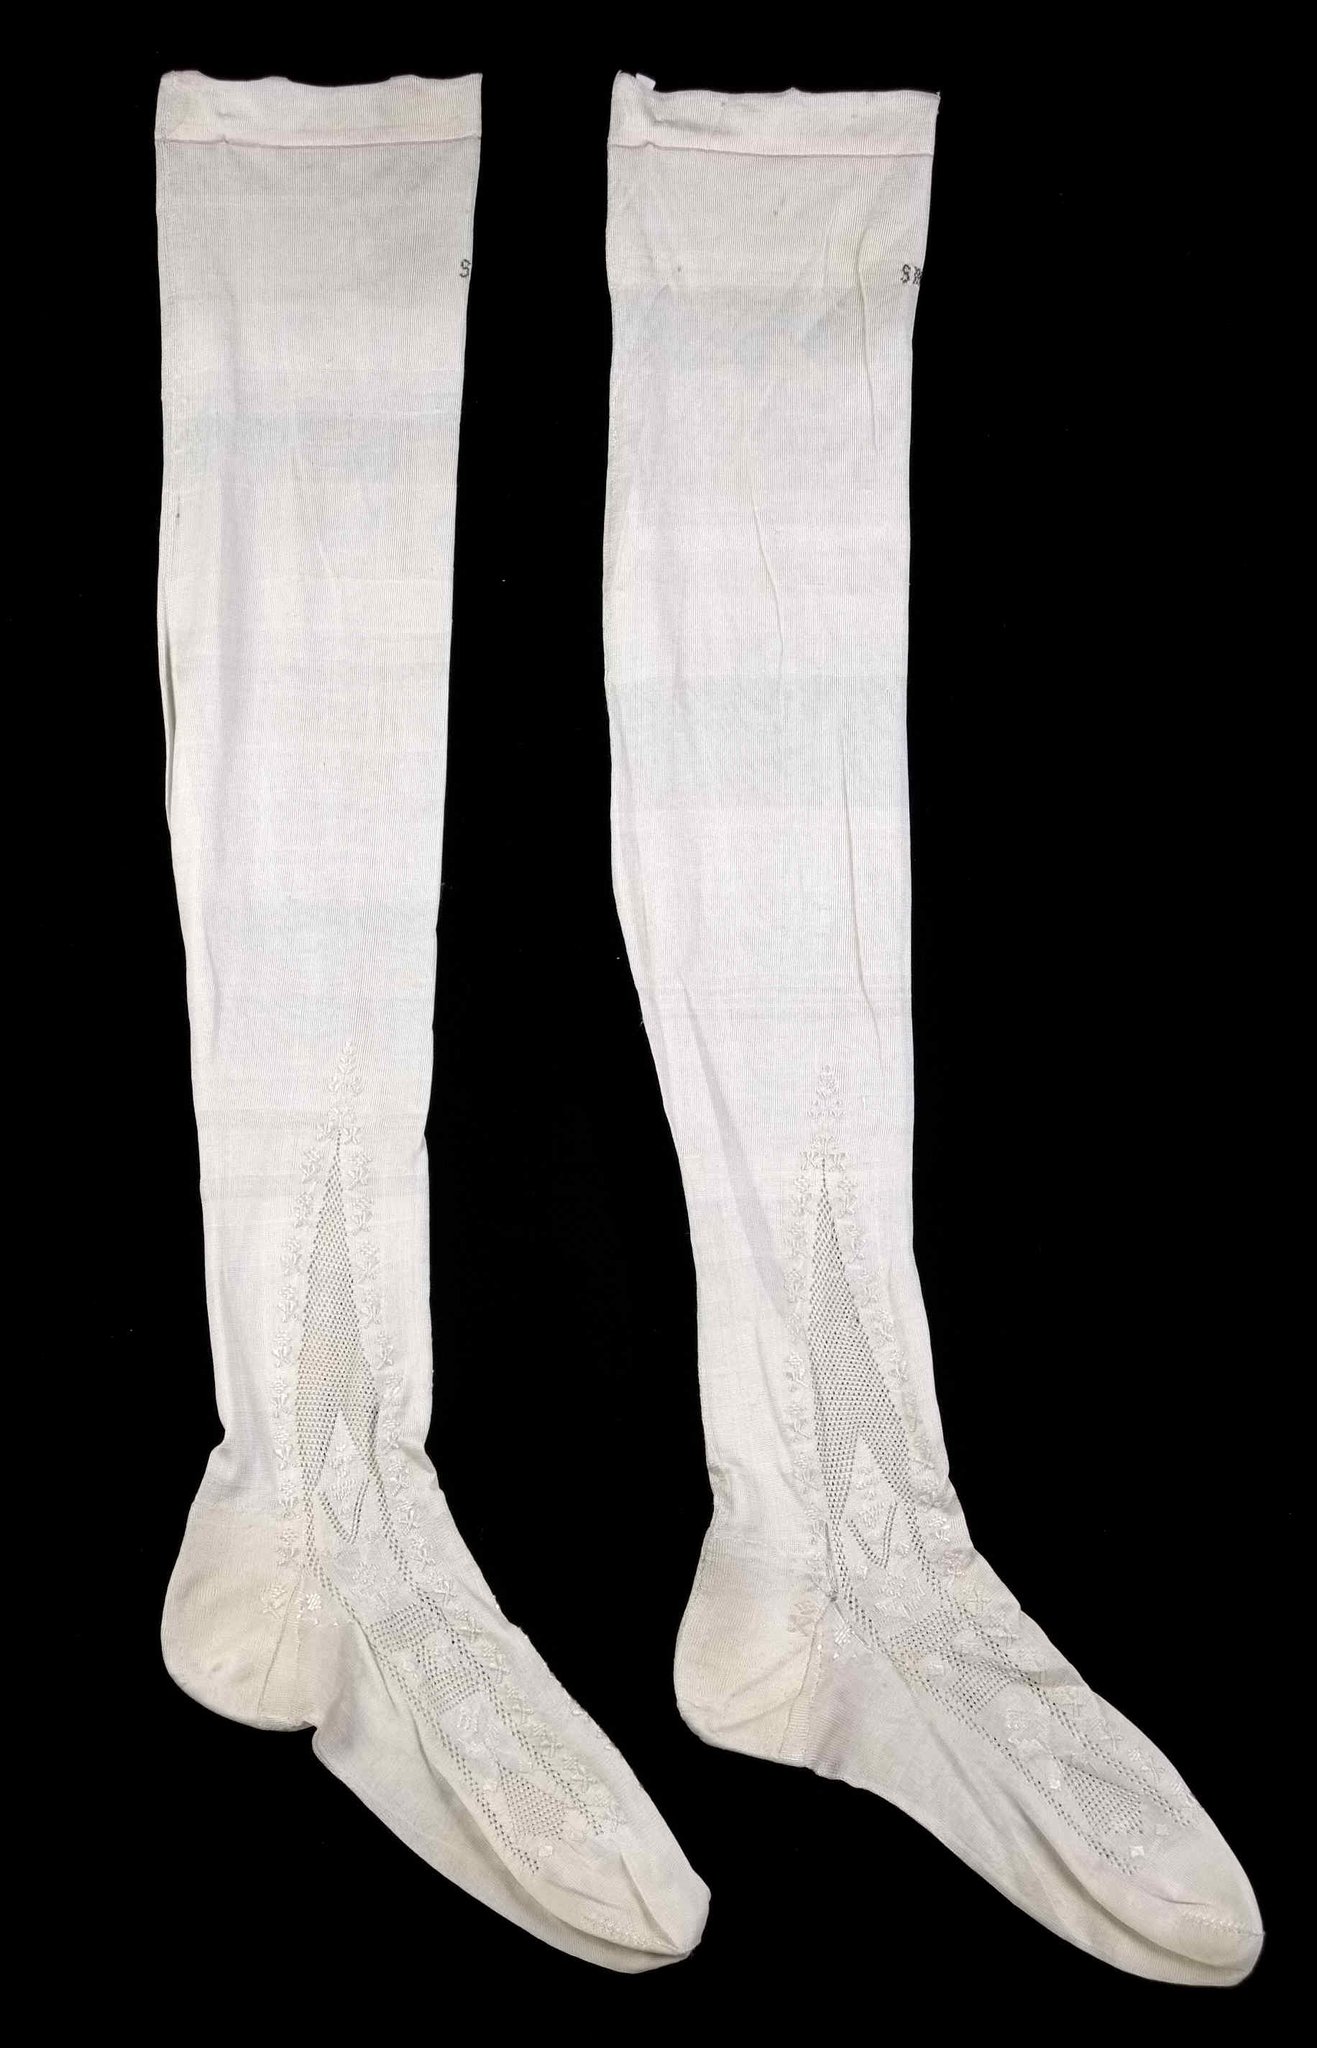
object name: stocking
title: Stockings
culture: american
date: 1850-1860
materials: silk